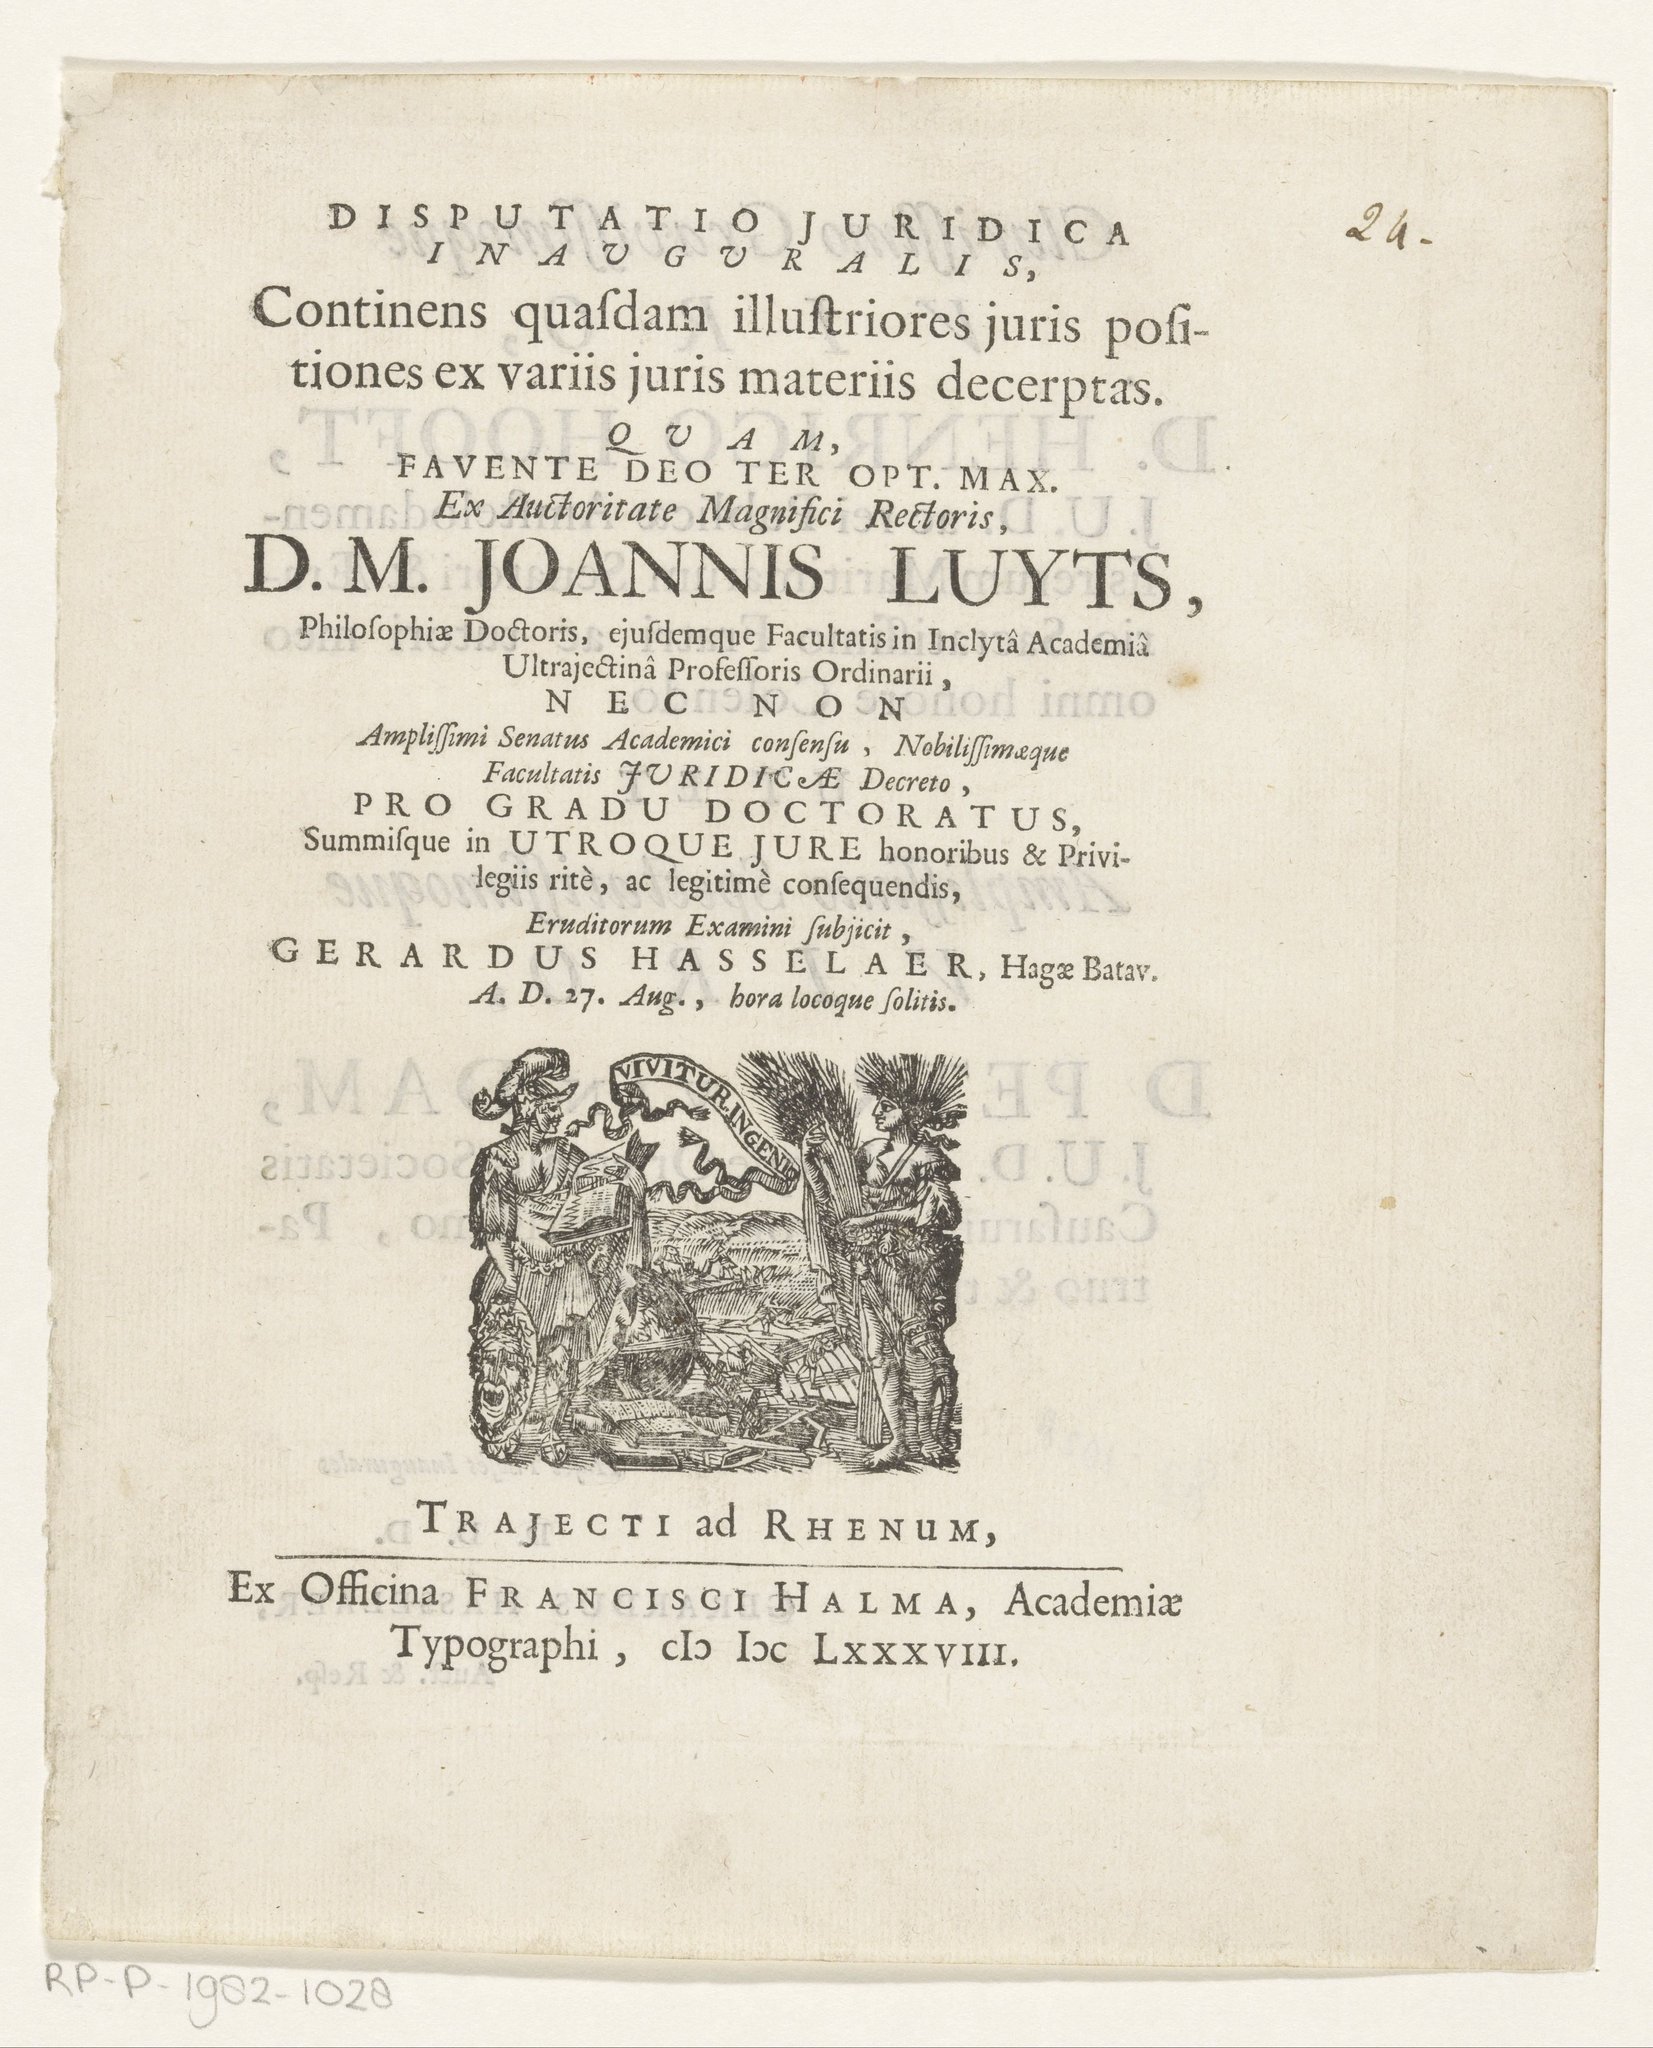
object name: print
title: Titelpagina voor: Johannes Luyts, Disputatio juridica inauguralis, 1688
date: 1688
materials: paper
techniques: letterpress printing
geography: utrecht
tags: (story of) ceres (demeter), (story of) minerva (pallas, athena)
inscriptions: collector's mark: Lugt 2228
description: Een vignet met Minerva met schild en boeken en Ceres met korenschoof. Tussen hen in een banderol met tekst Vivitur ingenio. In de achtergrond mensen werkend op het land.